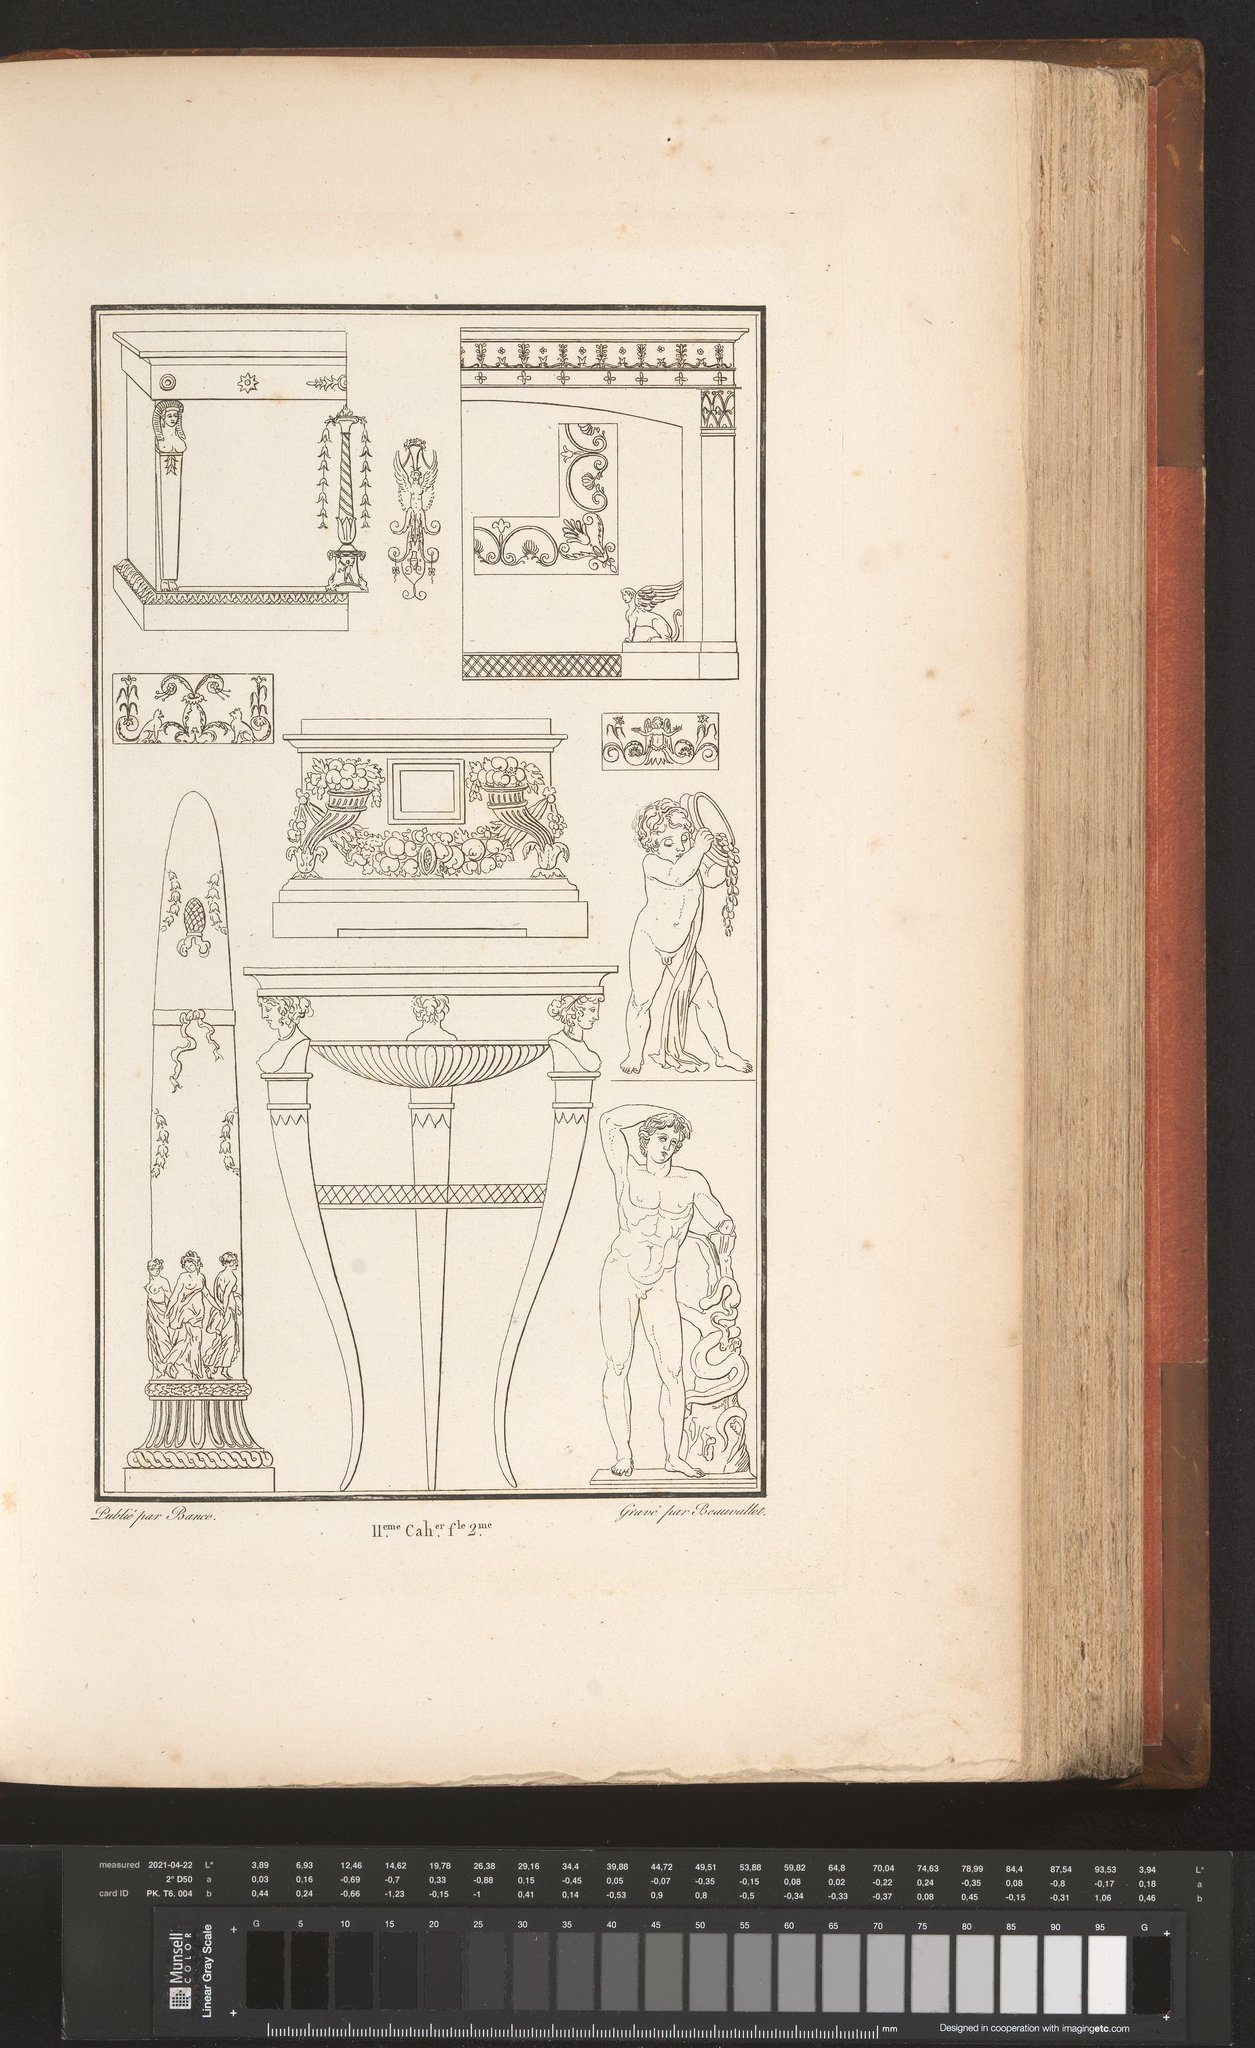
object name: ornament print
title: Diverse ornamenten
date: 1820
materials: paper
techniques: etching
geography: paris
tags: ornaments ~ art, house-altar ~ roman religion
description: Ornamentprent met diverse objecten, centraal een offerschaal op hoge voet. Onderdeel (11e. Cah. f.le 2) van het prentalbum met twee series van in totaal 138 ornamentprenten door Beauvallet en Normand, 'Fragmens d'Ornemens dans le Style Antique'.